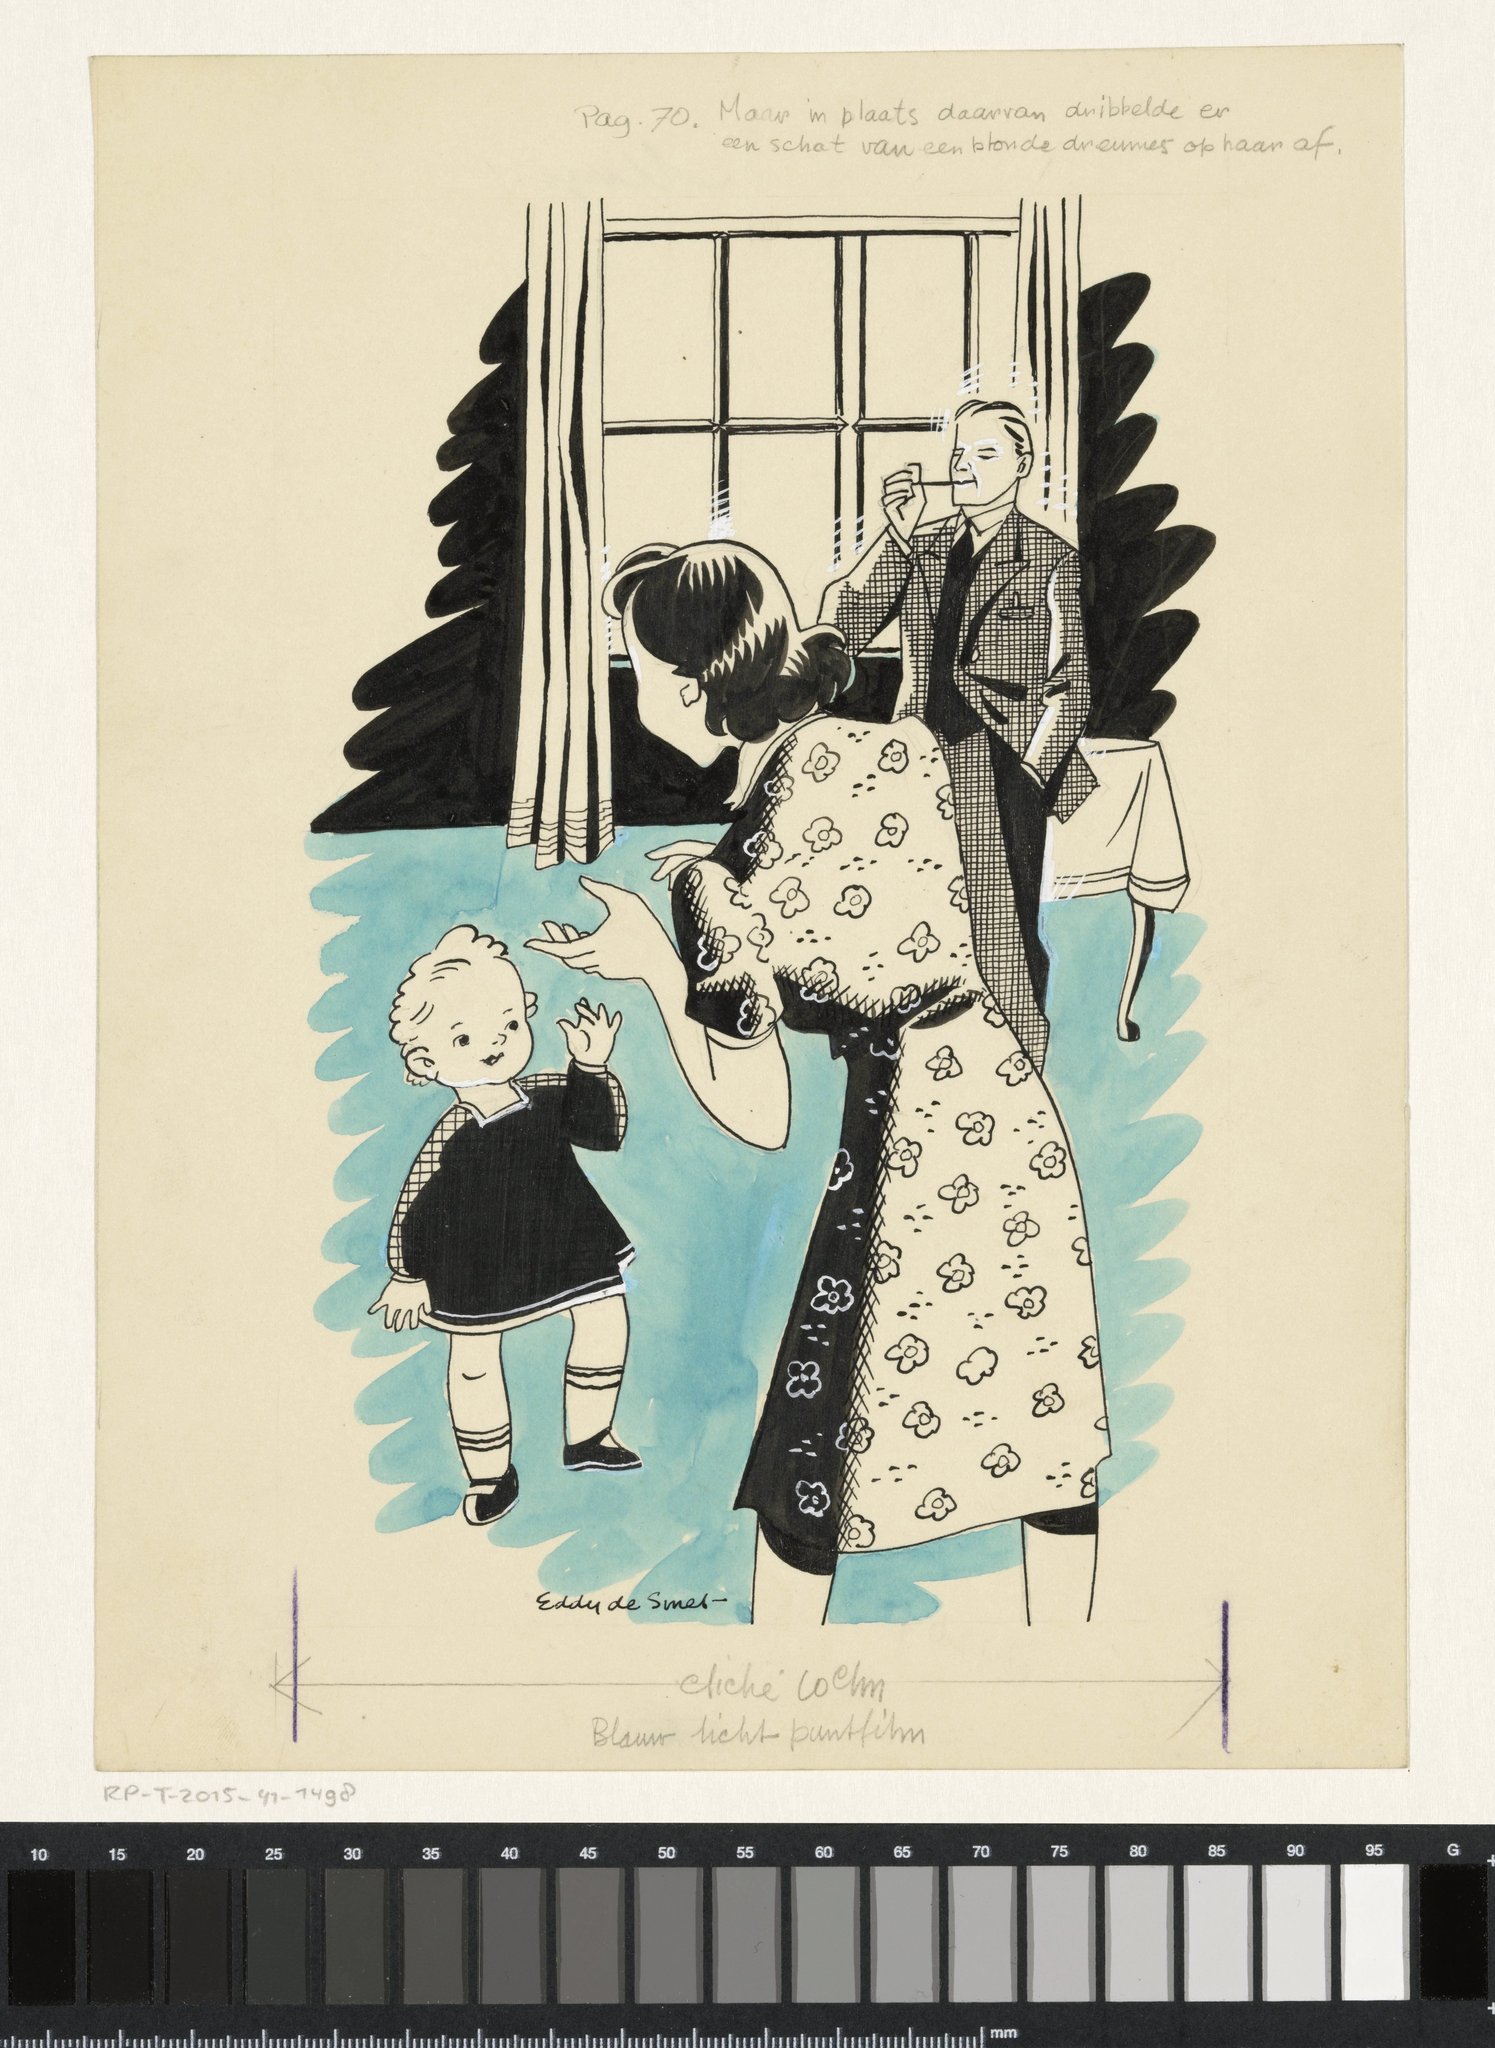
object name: boekillustratie ontwerp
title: Peuter loopt naar Marjo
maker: eddy de smet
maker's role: draughtsman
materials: paint, ink, paper, pencil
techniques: brush, pen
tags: toddler, pipe ~ tobacco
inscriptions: annotation: ‘Pag. 70. Maar in plaats daarvan dribbelde er/ een schat van een blonde dreumes op haar af.’, signature: ‘Eddy de Smet’, annotation: ‘Marjo’, collector's mark: Lugt 2228, :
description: Marjo staat in een kamer. Een peuter loopt naar haar toe. In de achtergrond bij het raam staat een man met een pijp in zijn mond.